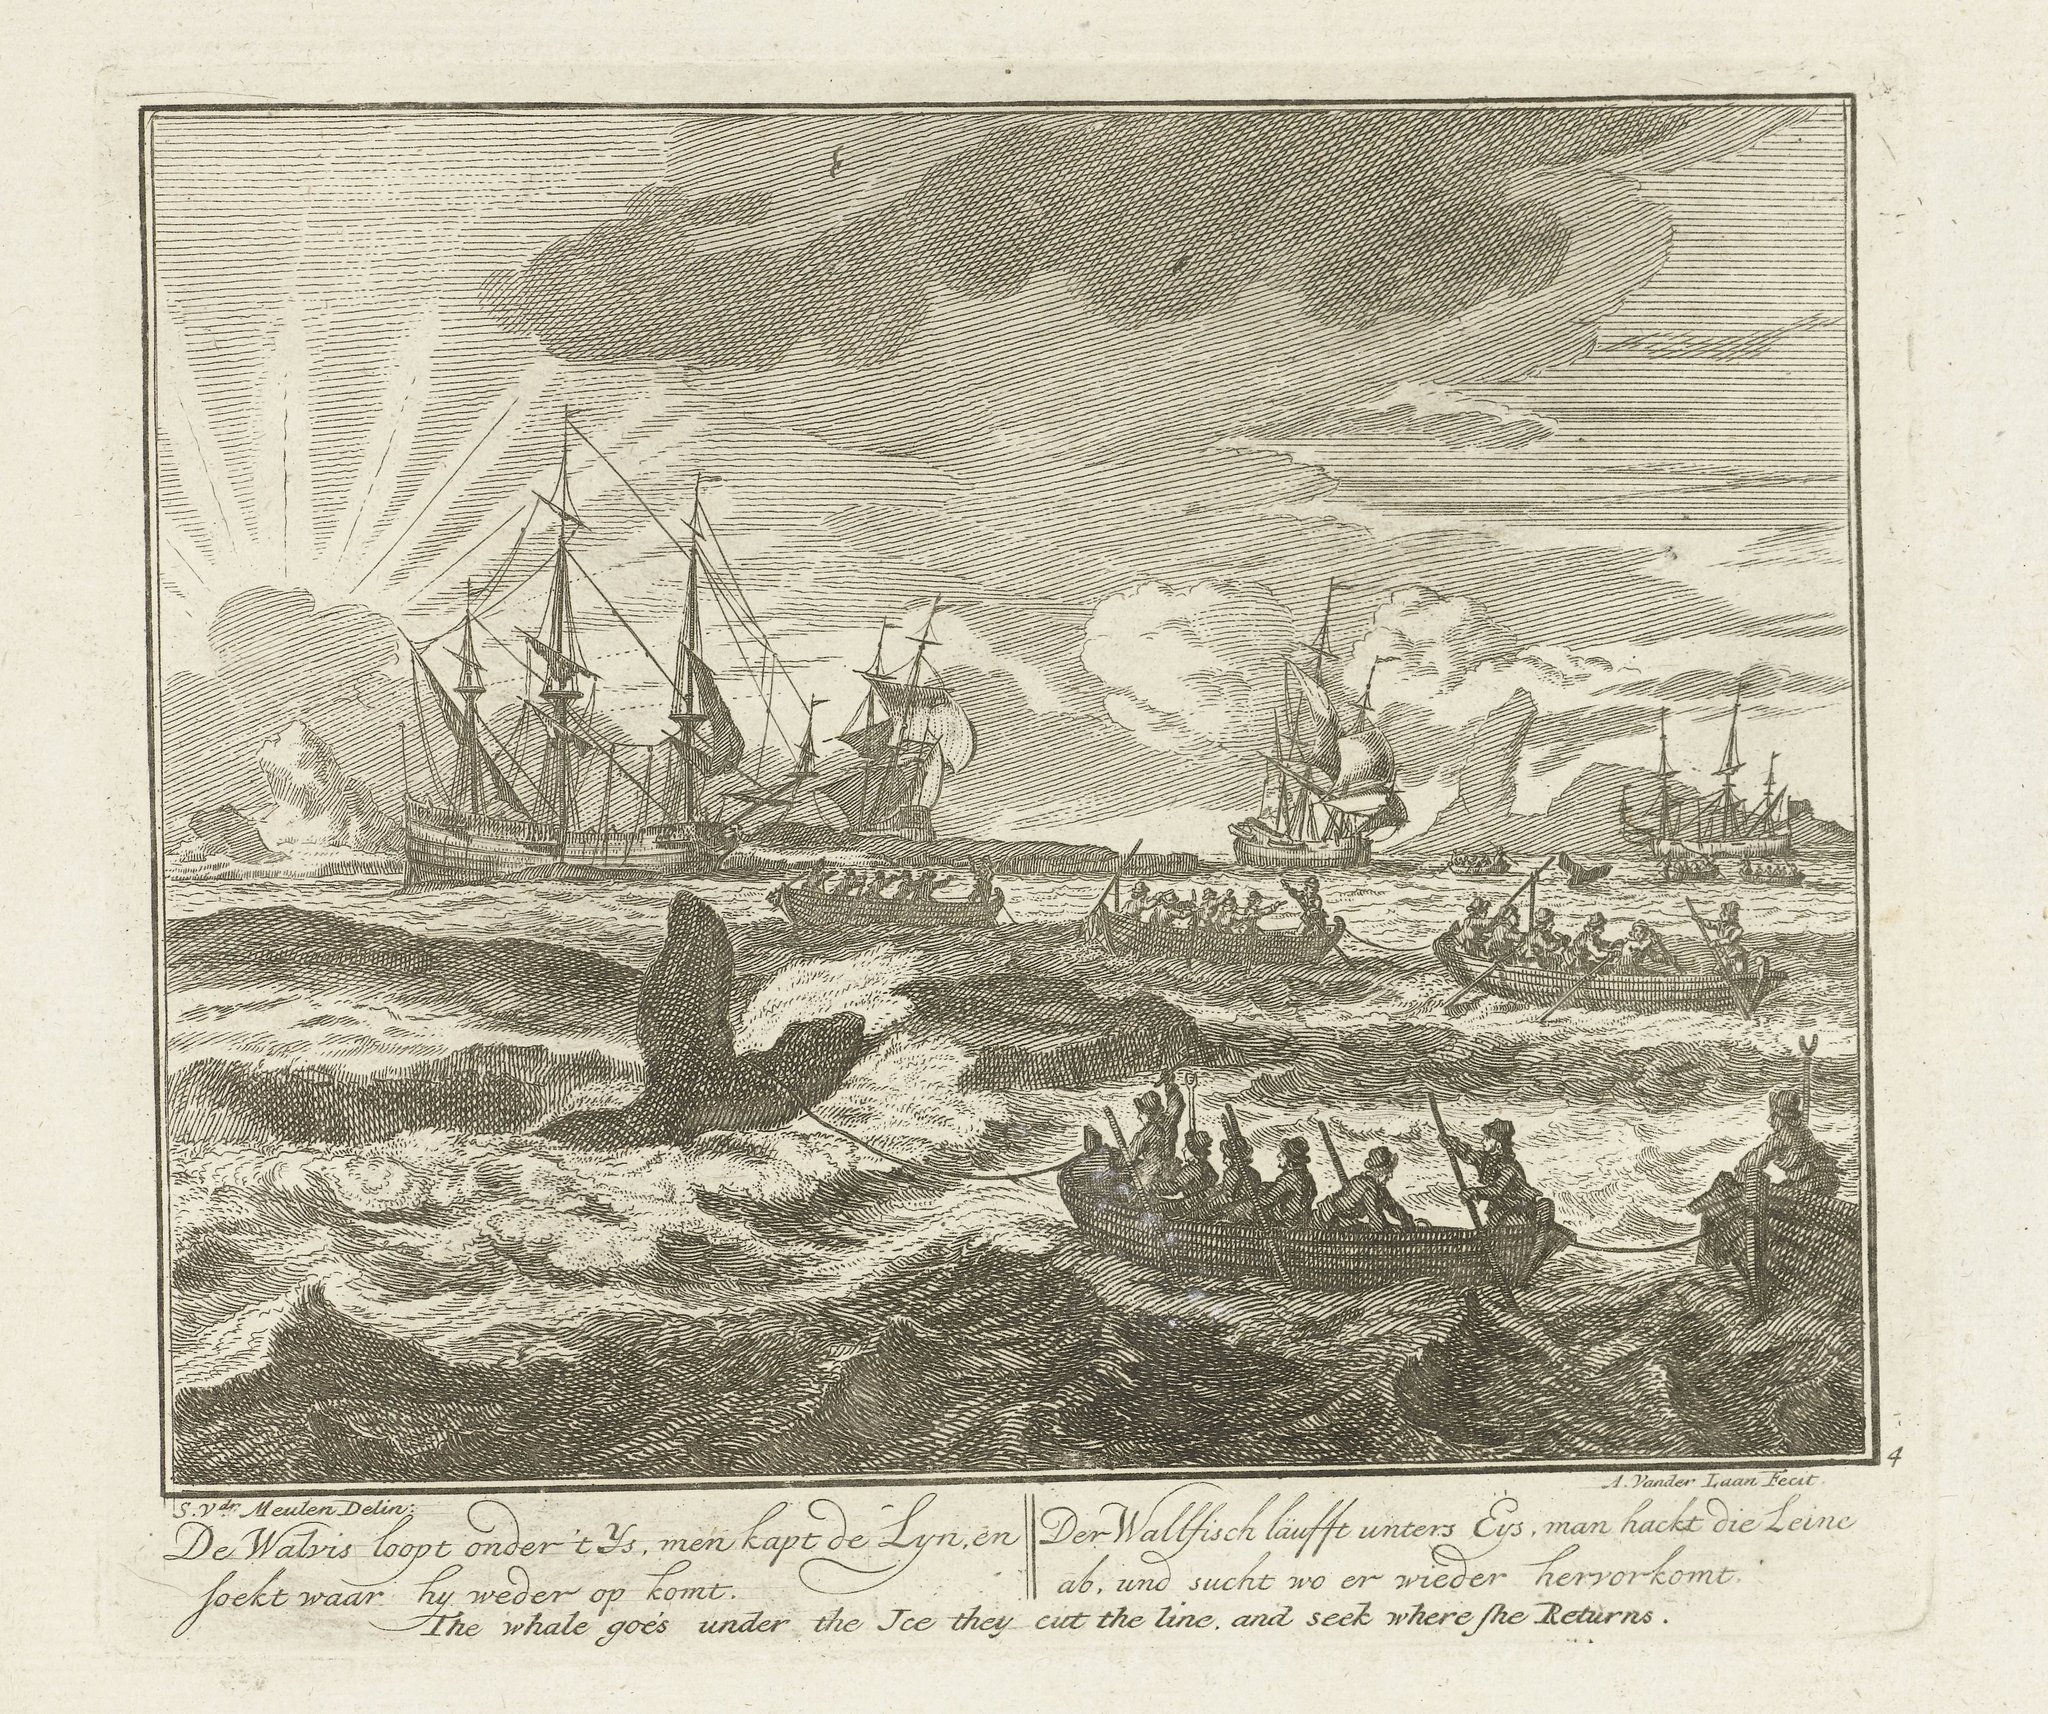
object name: print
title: Geharpoeneerde walvis duikt onder het ijs, ca. 1725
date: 1720-1730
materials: paper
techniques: etching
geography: amsterdam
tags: whale fishery, whaling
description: Als de geharpoeneerde walvis onder het ijs duikt wordt de lijn gekapt, ca. 1725. Onderdeel van de serie over de walvisvangst. Gedrukt op hetzelfde blad als nr. 3.